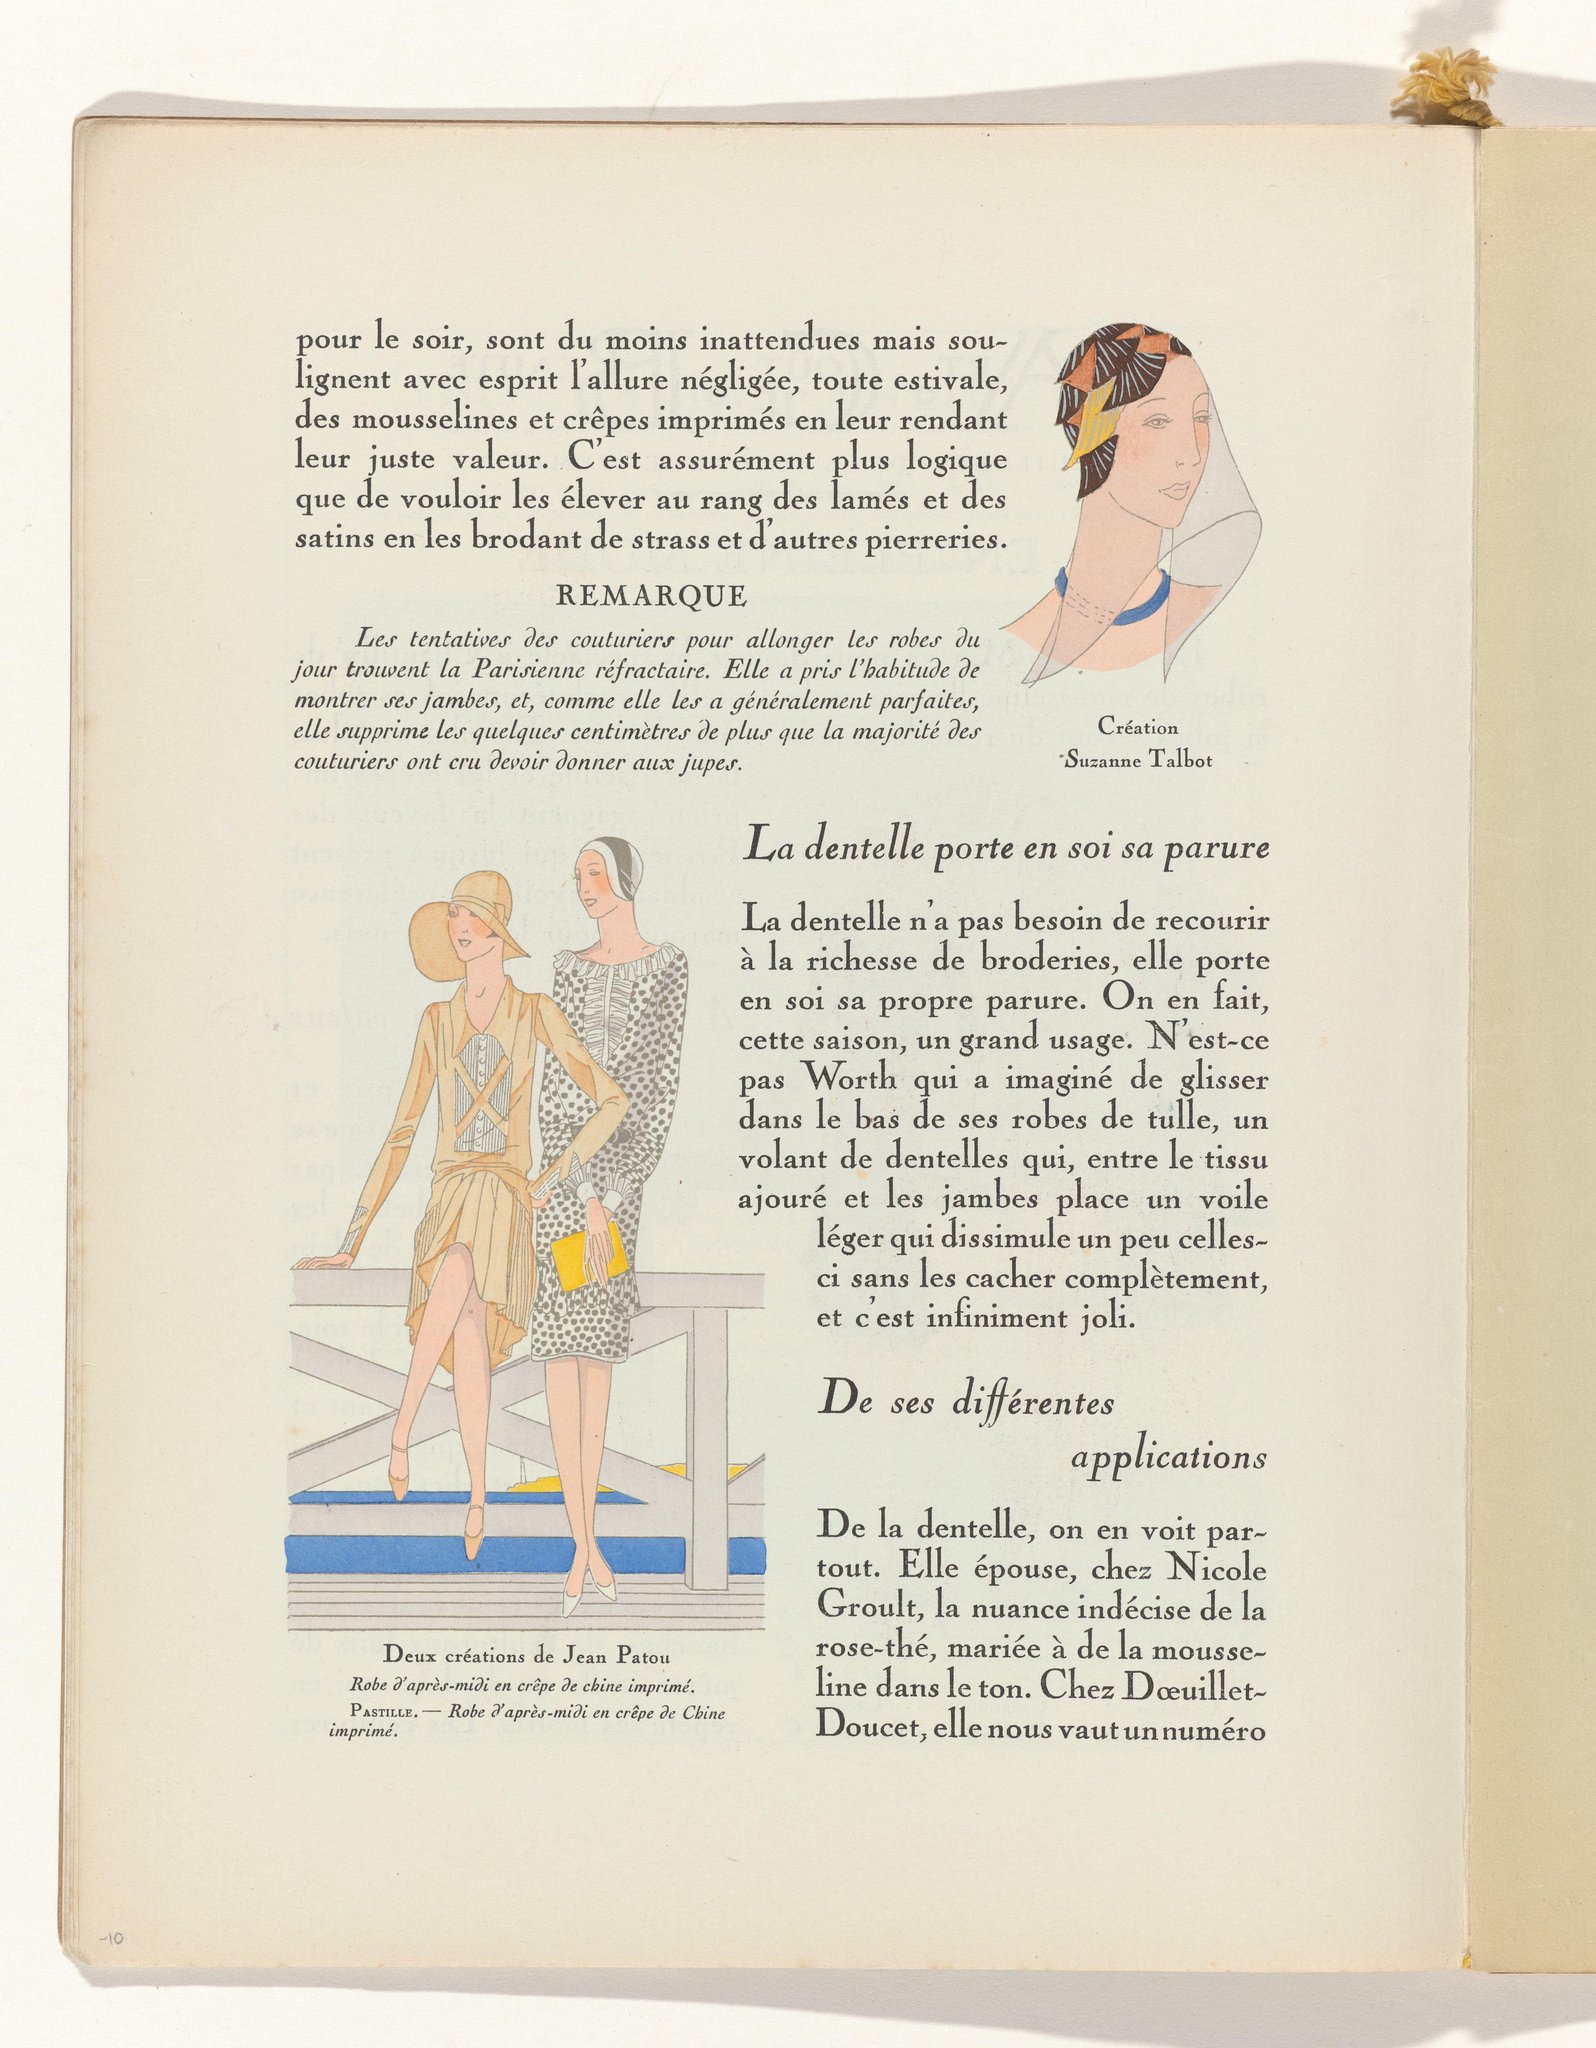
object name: magazine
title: Art - Goût - Beauté, Feuillets de l' élégance féminine, Mai 1929, No. 105, 9e Année, p. 10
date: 1929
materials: paper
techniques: hand coloring, lithograph, pochoir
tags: veil (+ women's clothes), dress, gown (afternoon dress) (+ women's clothes), fashion plates, head-gear: hat (+ women's clothes), balustrade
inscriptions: caption: ‘Deux créations de Jean Patou / Robe d'après-midi en crêpe de chine imprimé. PASTILLE.- Robe d'après-midi en crêpe de Chine imprimé.’, caption: ‘Création Suzanne Talbot’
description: Tekst over 'kant'. Illustraties: vrouwenhoofd met hoedje met voile van Susanne Talbot; twee middagjaponnen van crêpe de chine van Jean Patou. Pagina uit het modetijdschrift Art-Goût-Beauté (1920-1933).